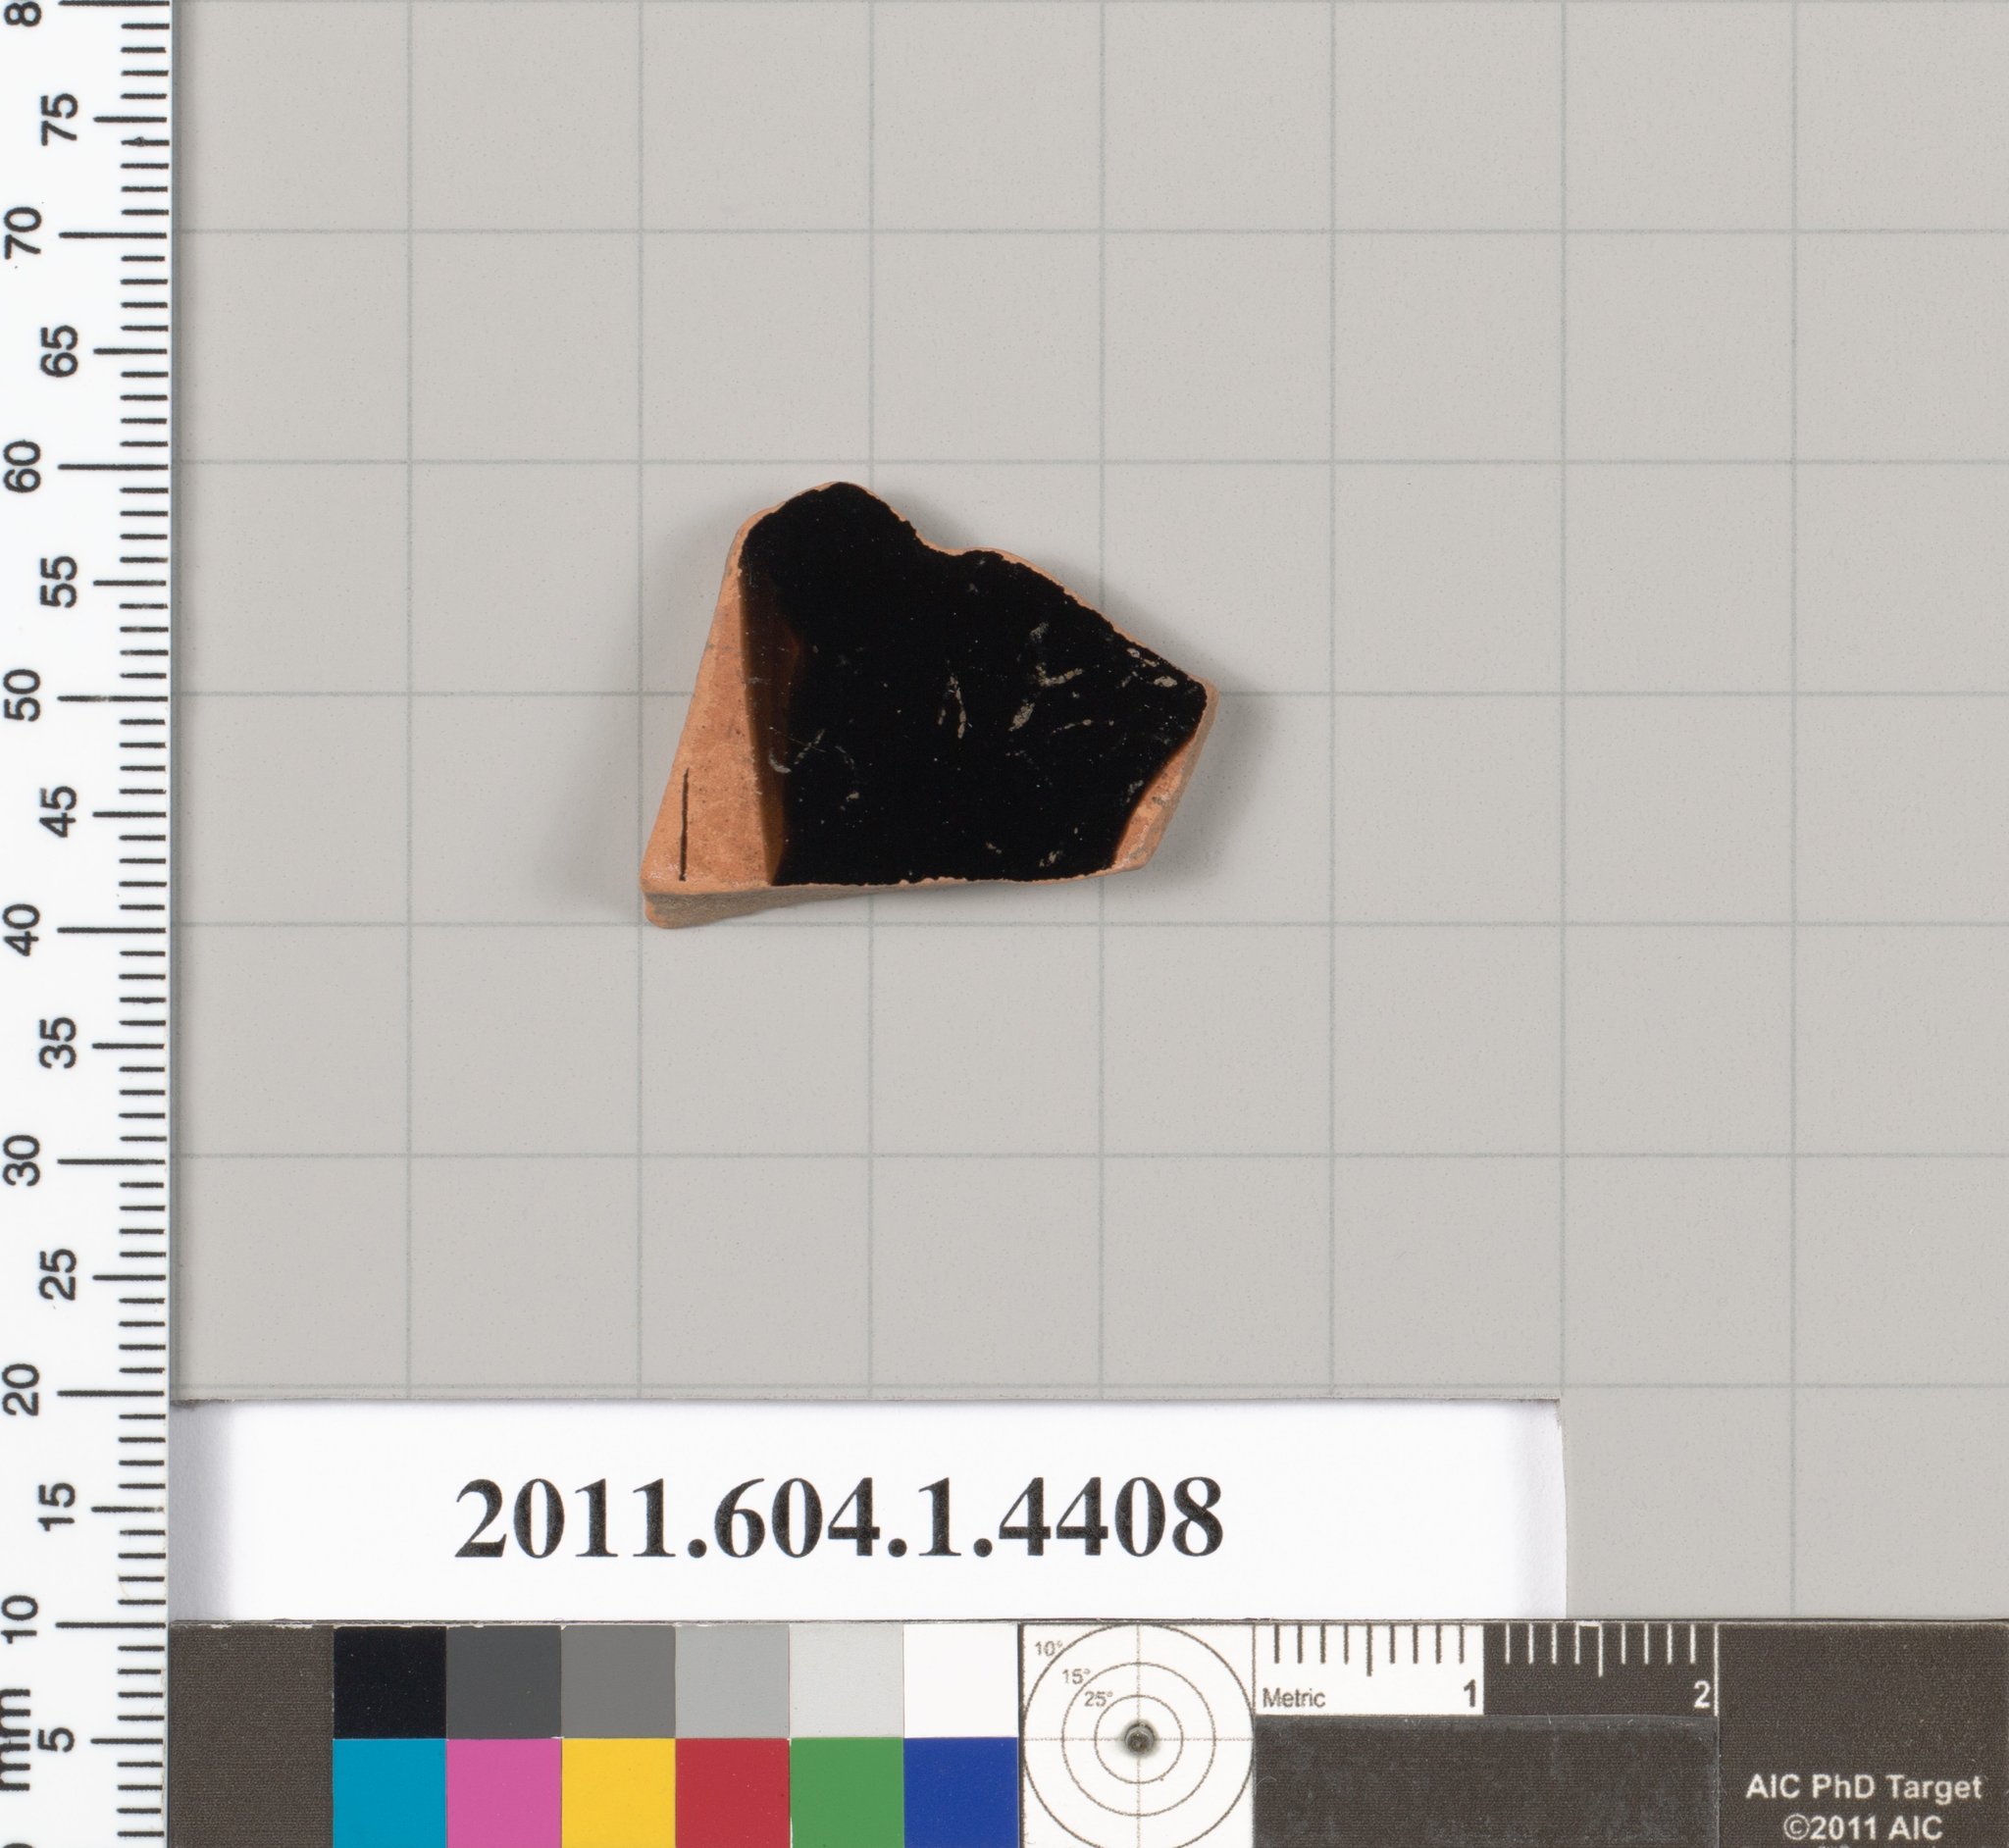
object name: kylix fragment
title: Terracotta fragment of a kylix (drinking cup)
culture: greek, attic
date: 475-451 BCE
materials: terracotta